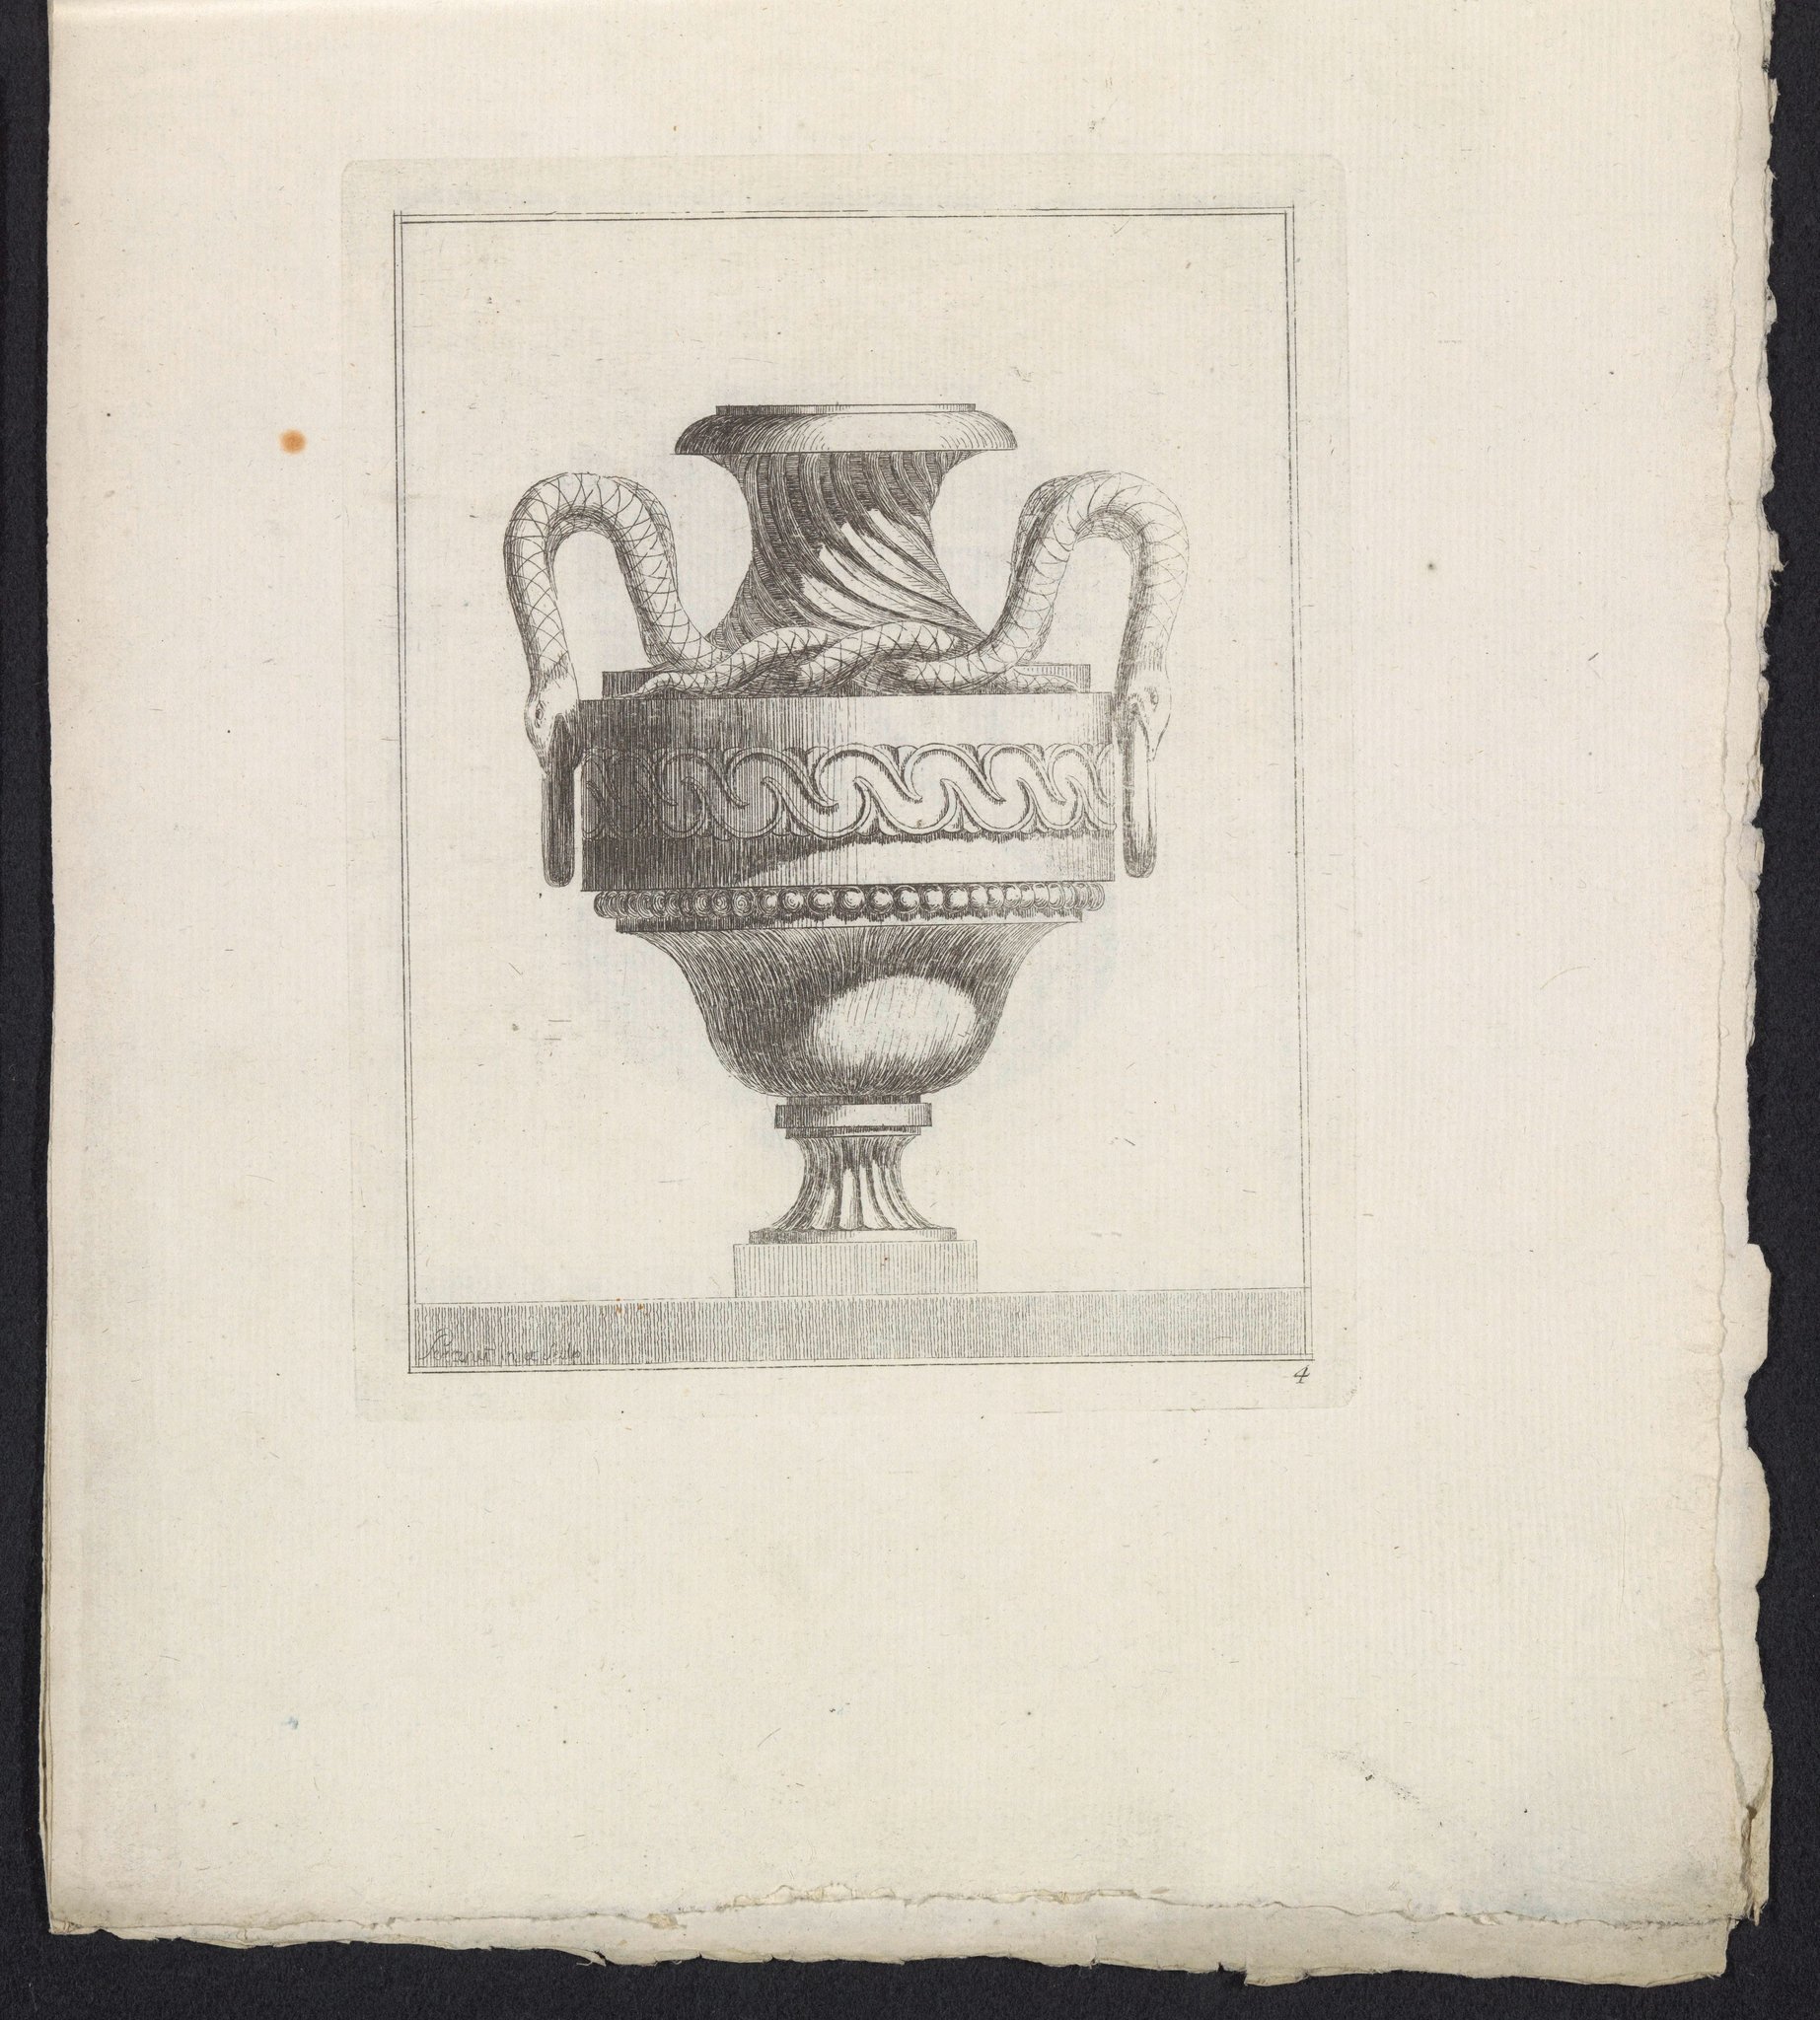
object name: ornament print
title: Vaas met slangen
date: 1755-1768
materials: paper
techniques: etching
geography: paris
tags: snakes, vase ~ ornament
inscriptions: collector's mark: Lugt 2228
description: Een geornamenteerde vaas met geornamenteerde rand en slangen met ringen in de bek als handvaten.